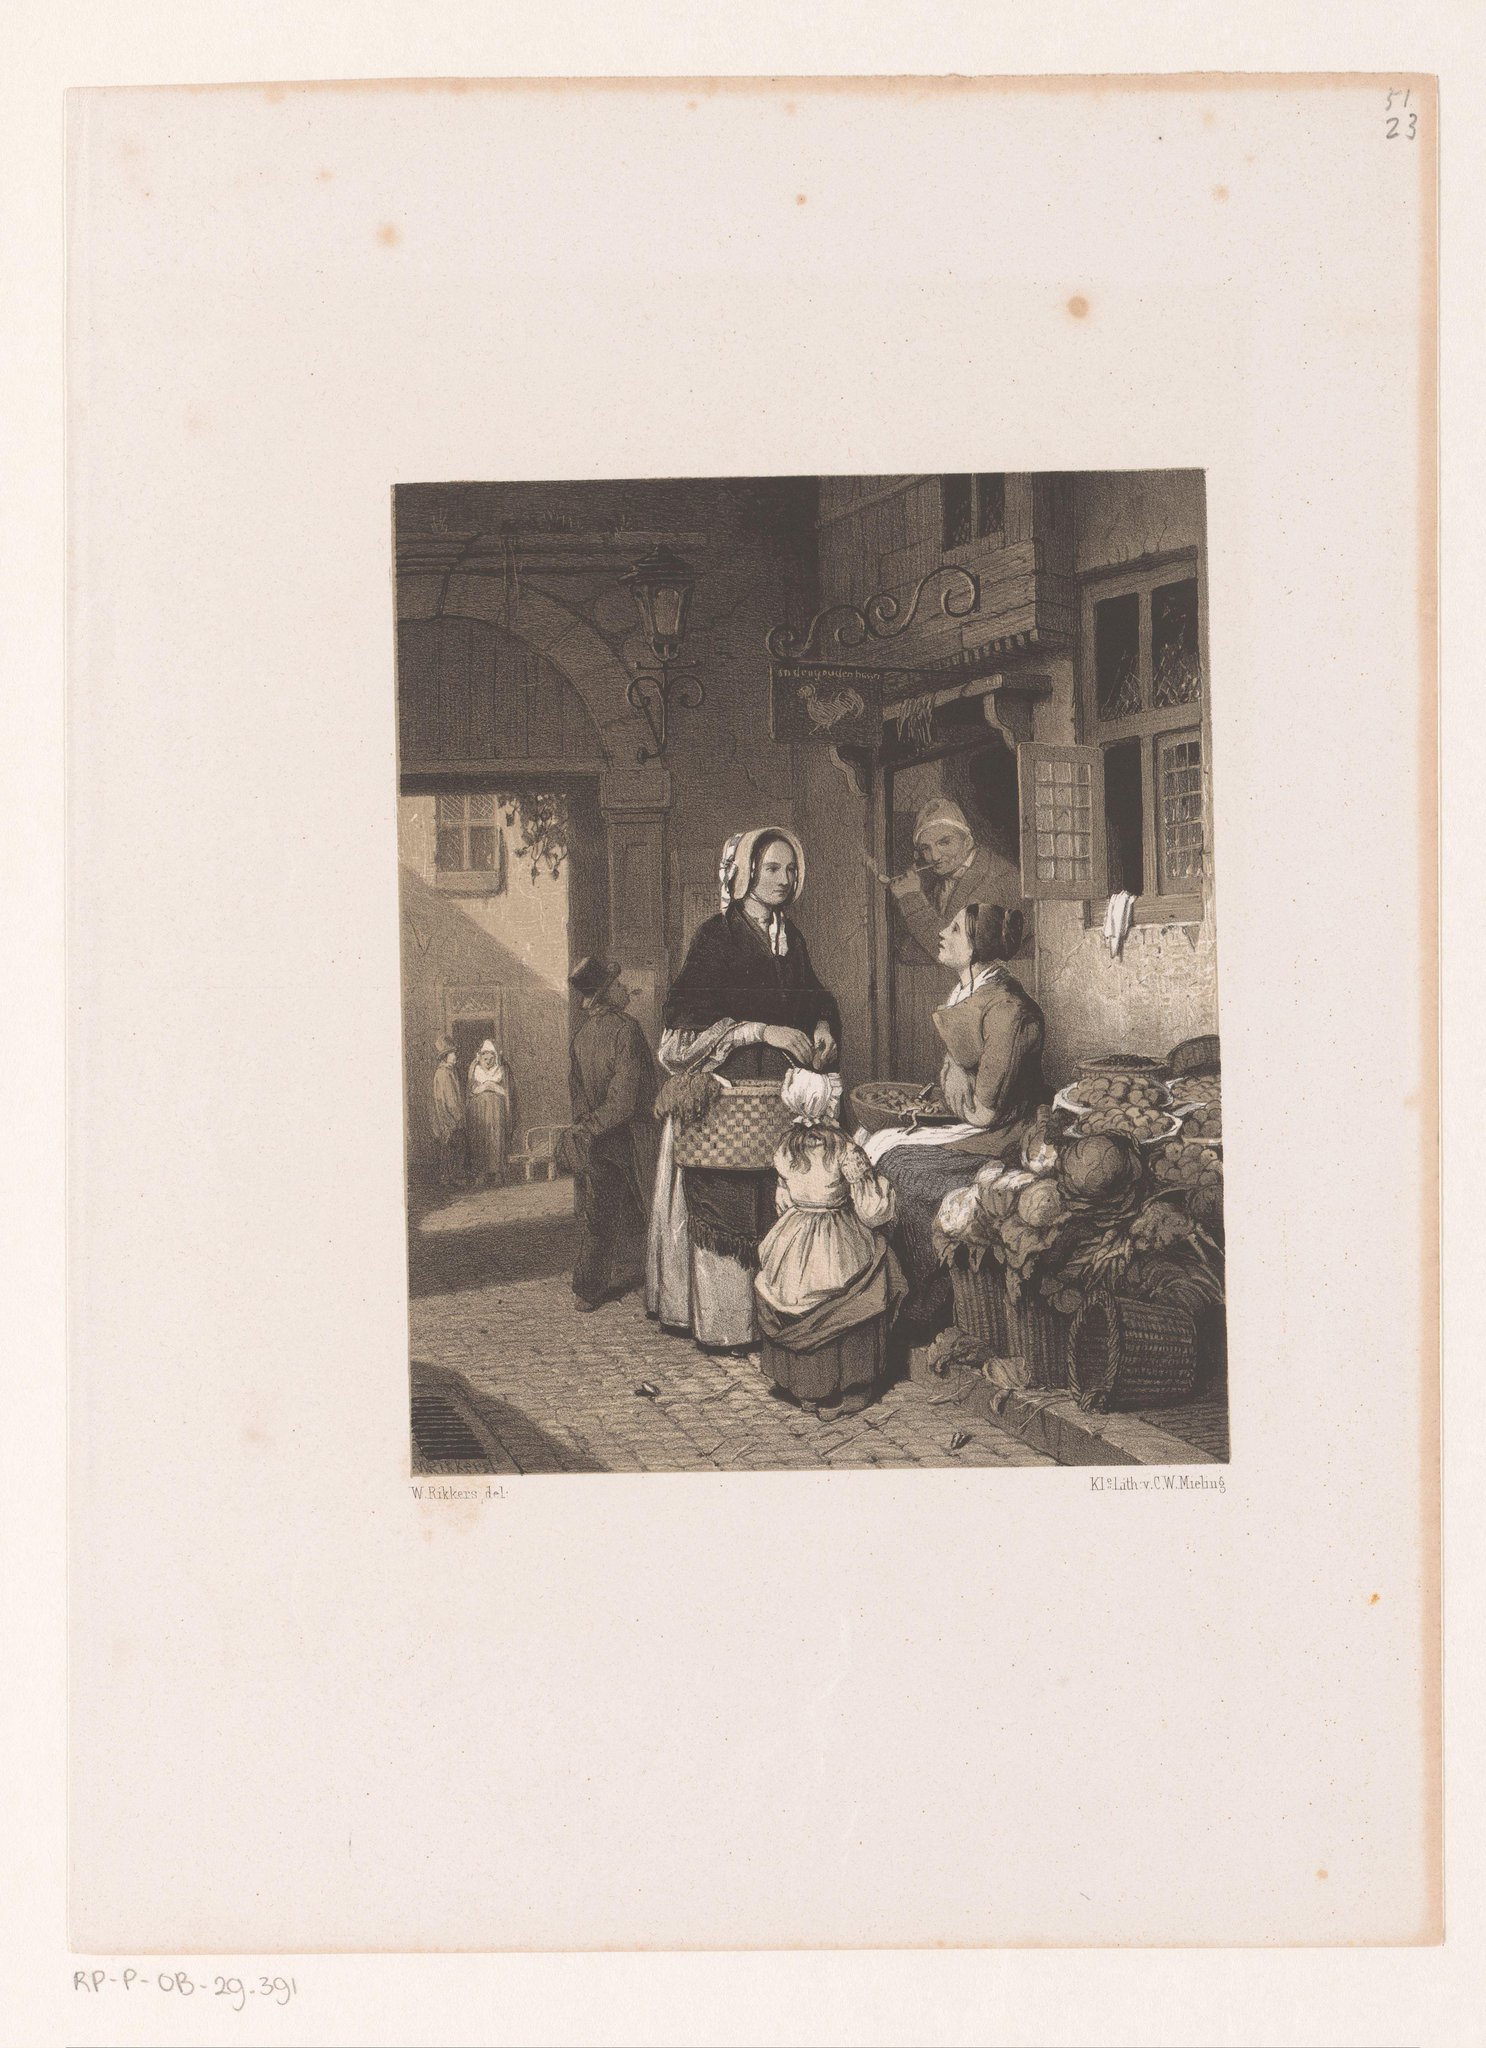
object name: print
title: Groenteverkoopster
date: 1847-1865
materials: paper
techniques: tone lithography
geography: amsterdam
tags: vegetables, selling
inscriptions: collector's mark: Lugt 2228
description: Een verkoopster zit tussen manden gevuld met groente voor een gebouw met uithangbord In den gouden haan. Bij haar staan een vrouw met mand en een kind. Door het bovenste deel van de boerendeur kijkt een pijprokende man naar buiten.